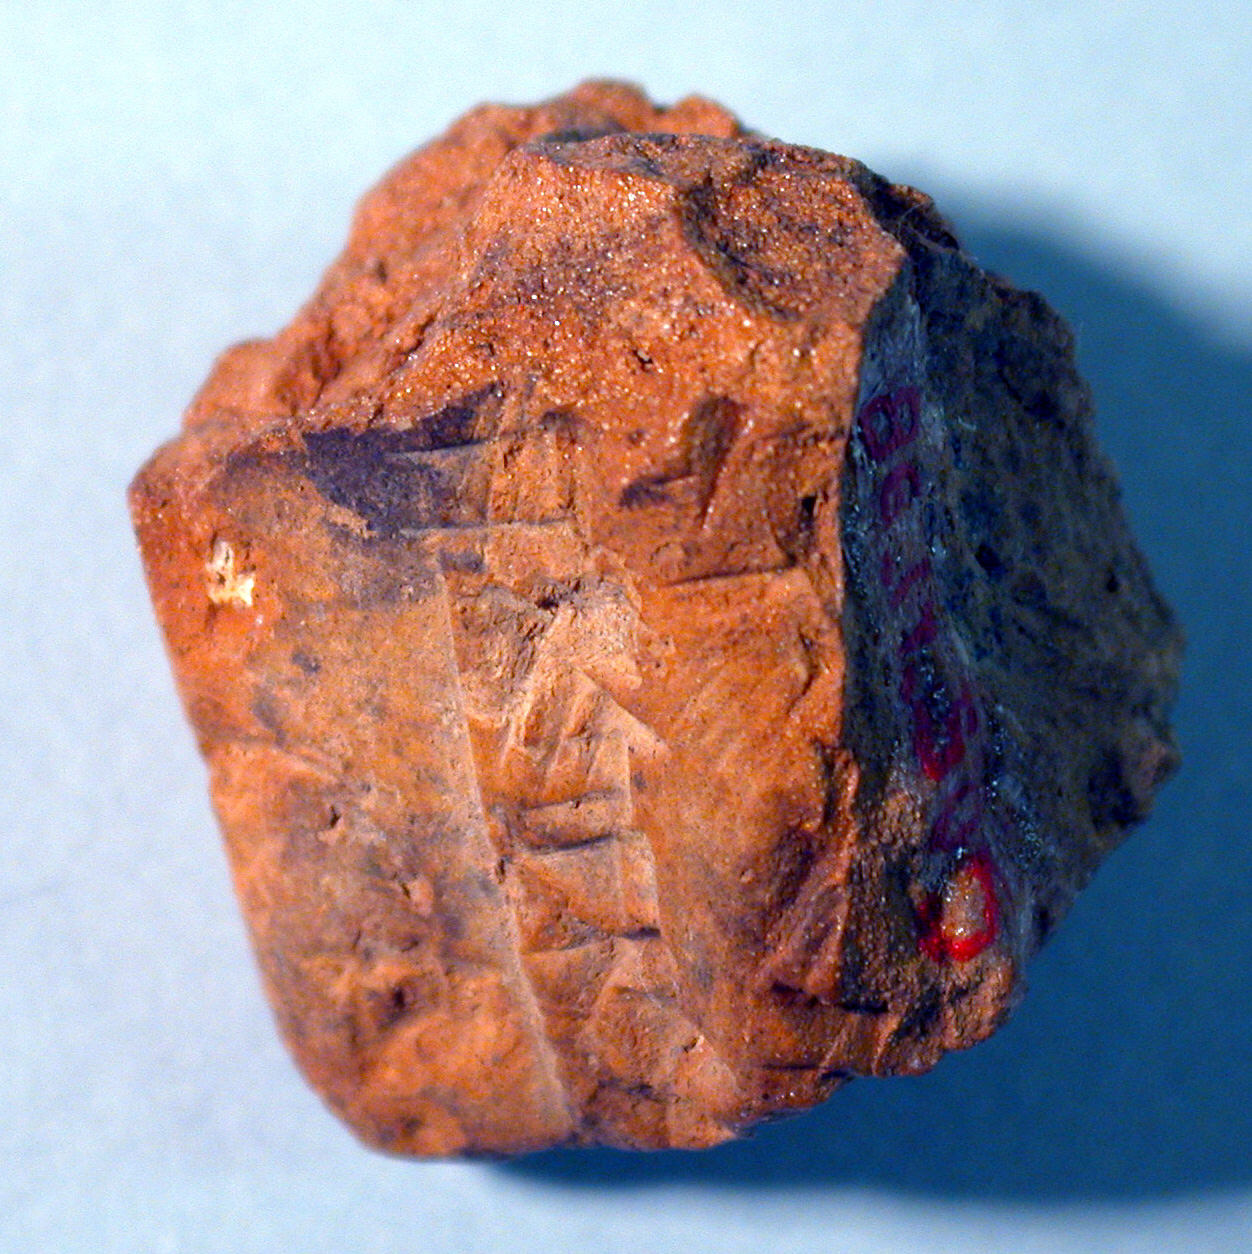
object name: cuneiform tablet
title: Cuneiform tablet: fragment, content uncertain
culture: achaemenid or babylonian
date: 700-301 BCE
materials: clay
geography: mesopotamia